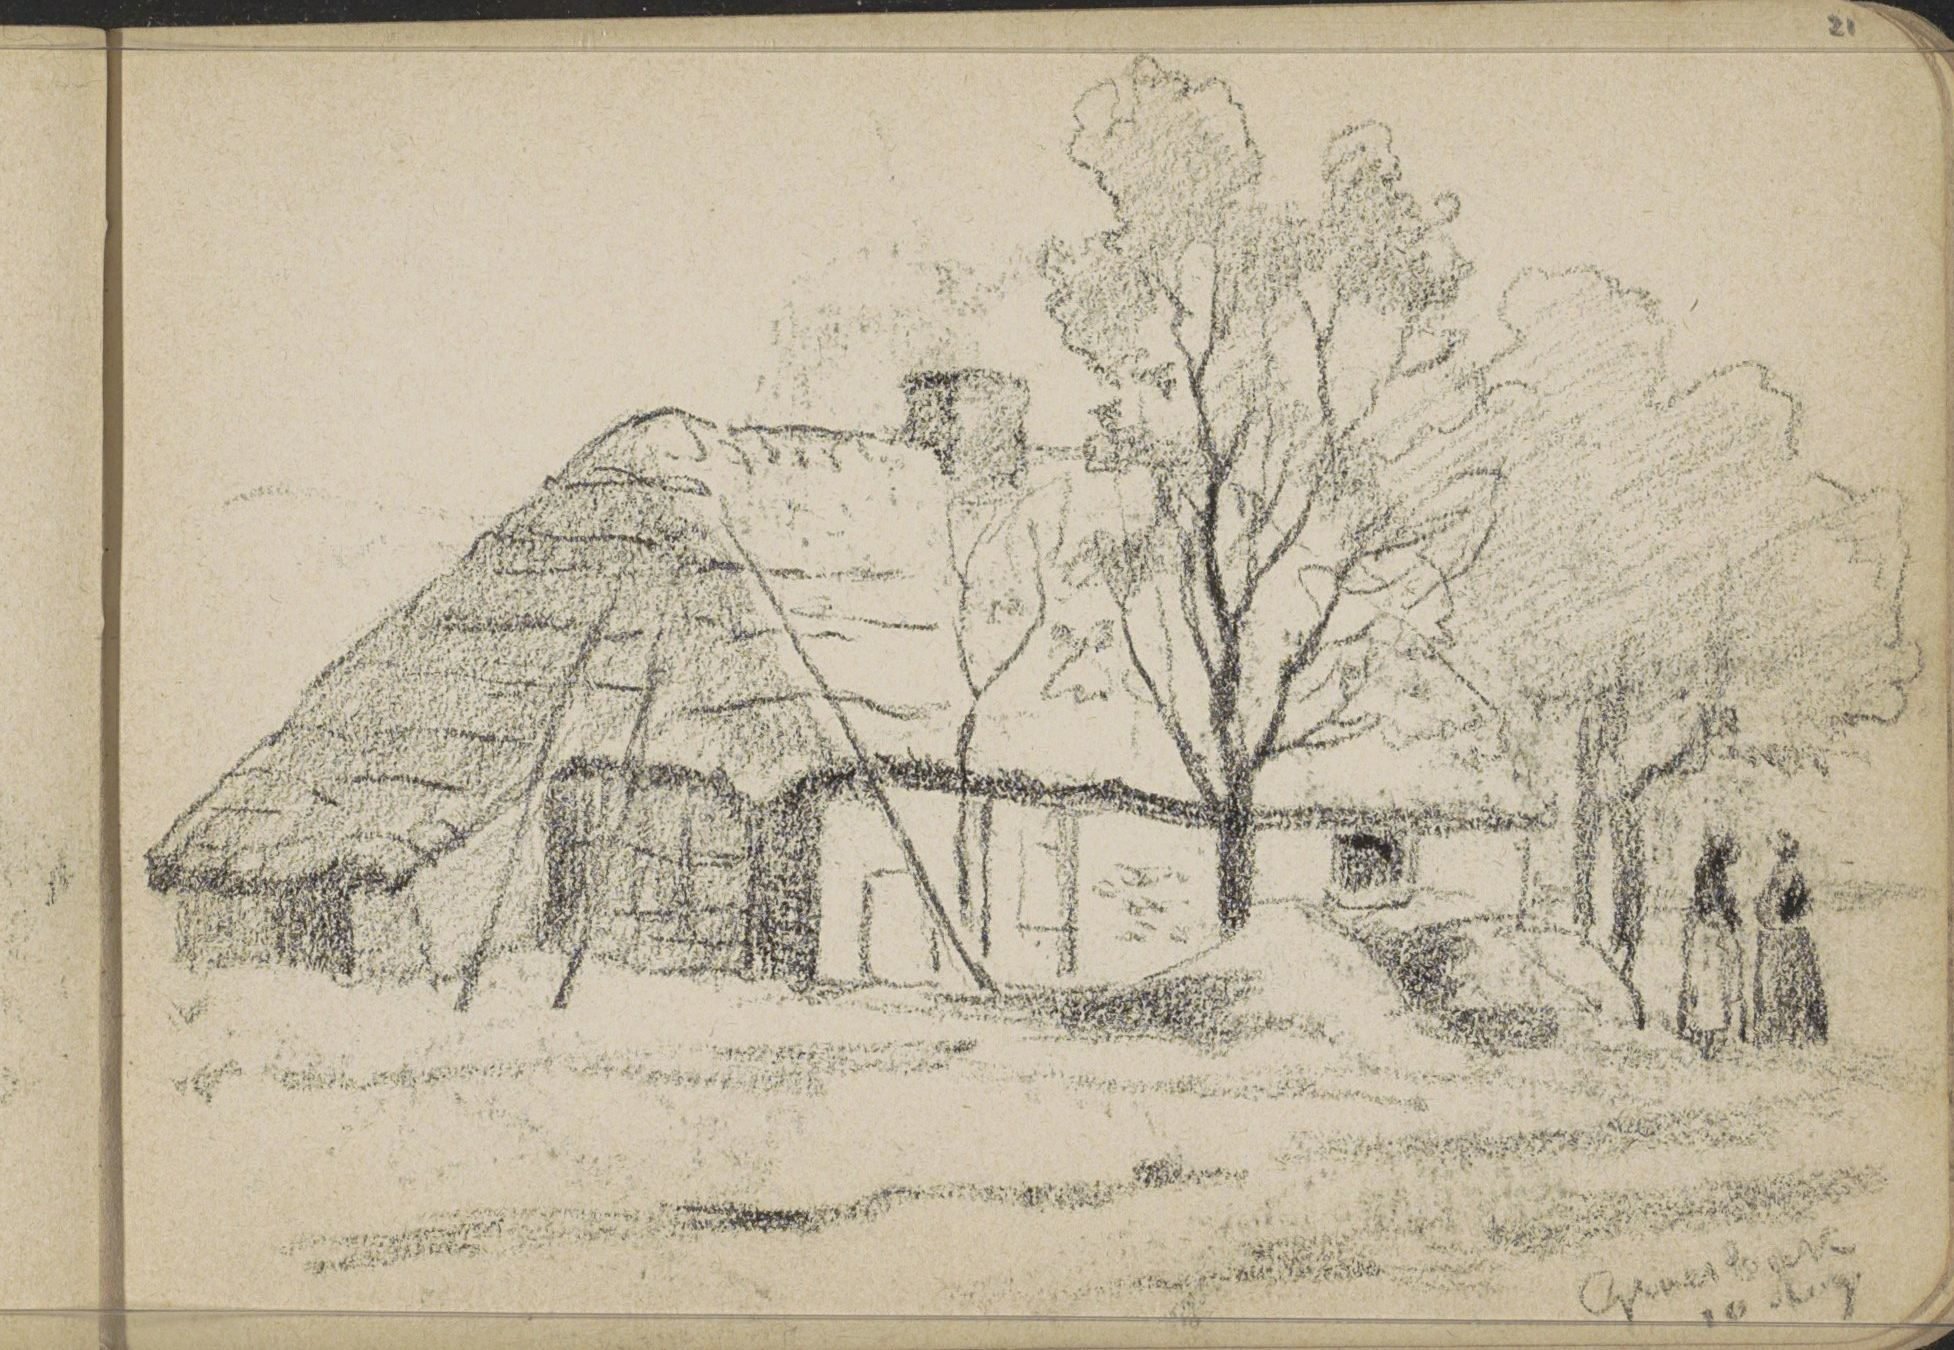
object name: sketchbook leaf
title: Twee boerinnen bij een boerderij te Groesbeek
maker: willem cornelis rip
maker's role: draughtsman, painter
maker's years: 1856-1922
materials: chalk, paper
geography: groesbeek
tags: farmers - aa - female farmer, farmer's wife, farm (building)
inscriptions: date and inscription: ‘Groesbeek/ 10 Aug.’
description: Blad 21 recto uit een schetsboek met 44 bladen.